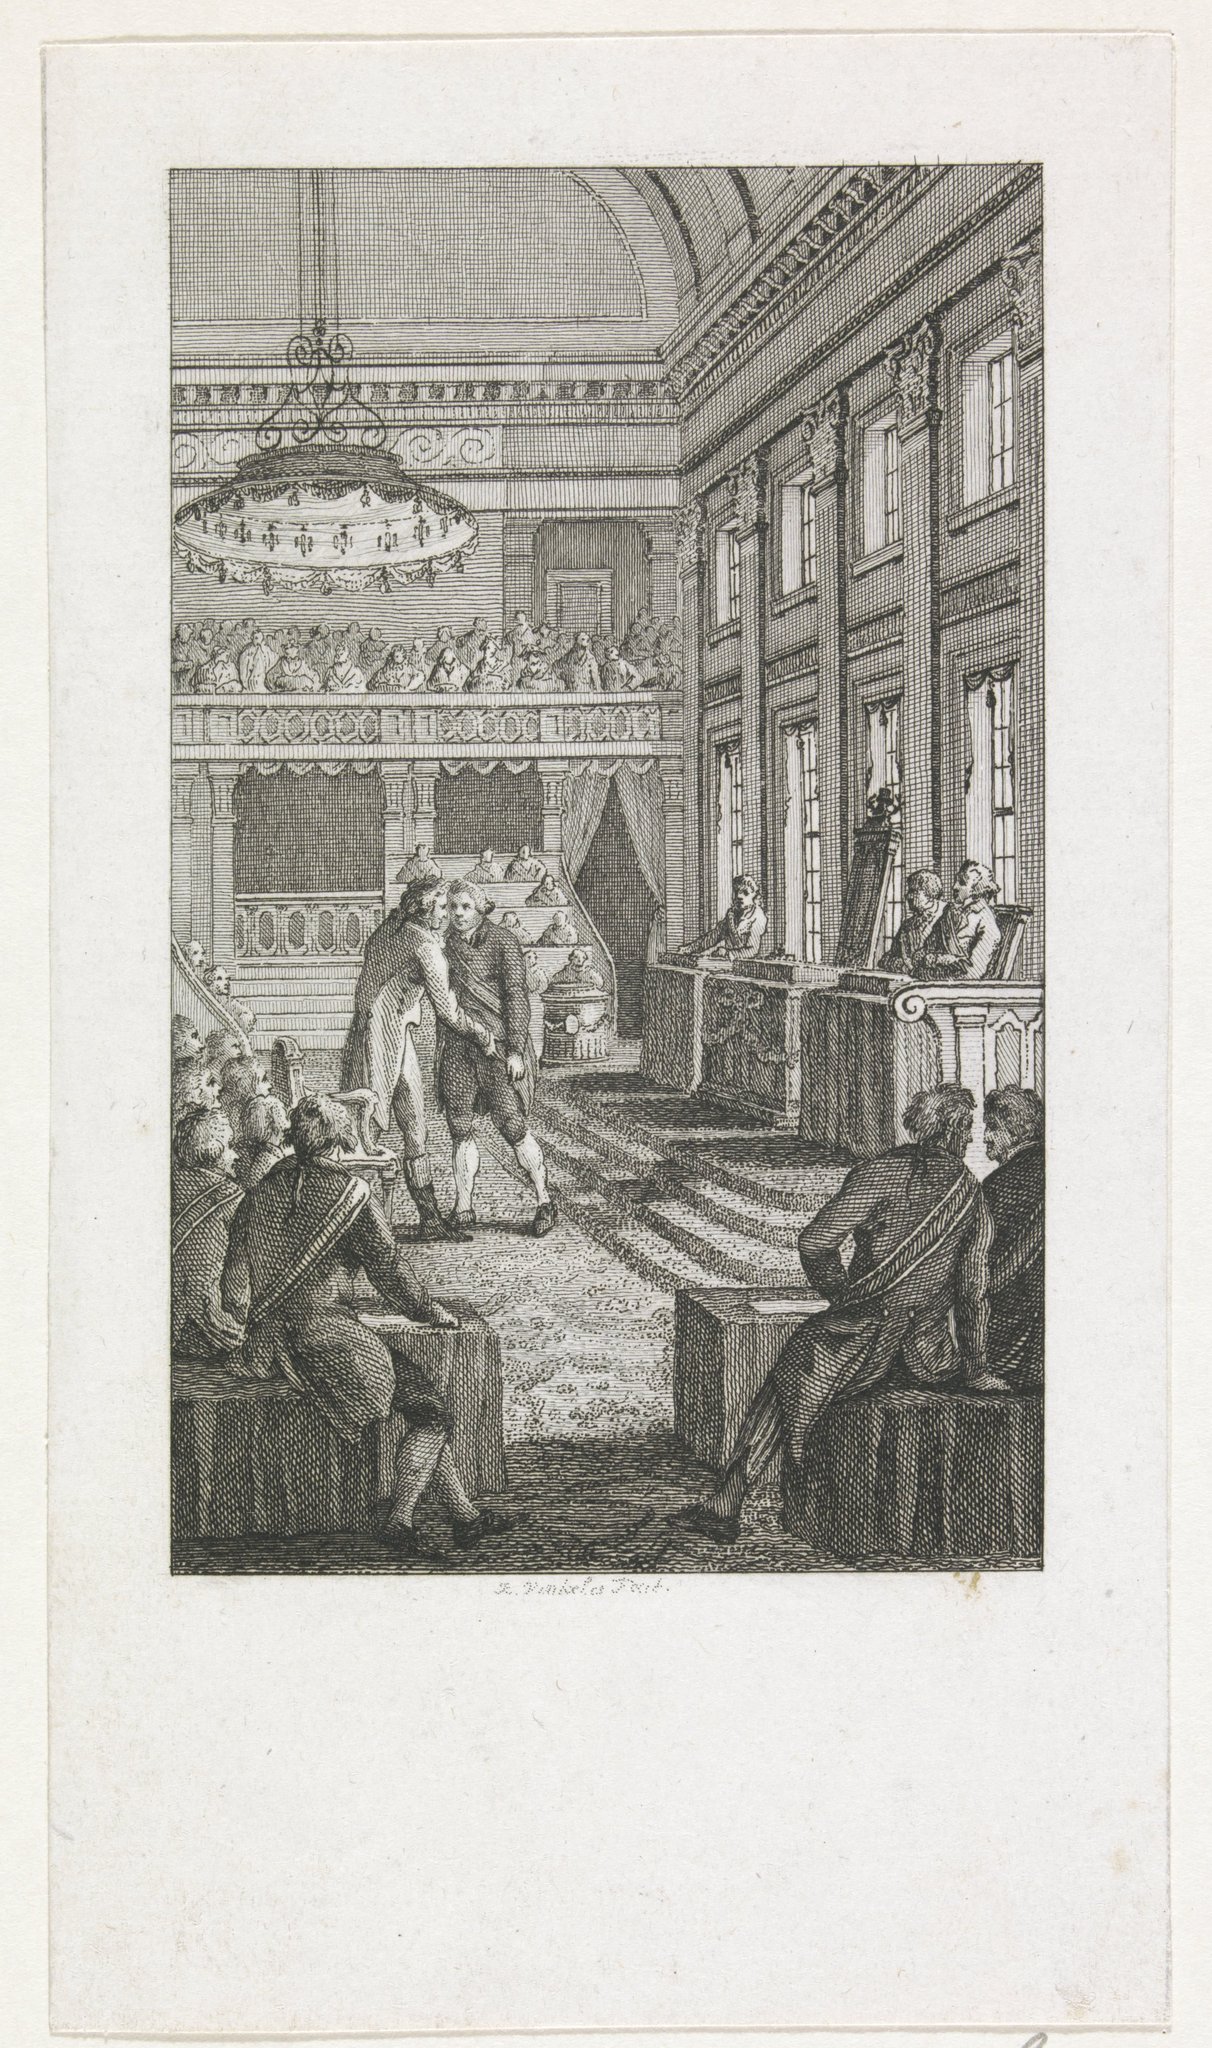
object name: history print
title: Voorzitter Midderigh van de Nationale Vergadering geeft de Franse afgezant De La Croix de broederkus, 1798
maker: reinier vinkeles (i)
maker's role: draughtsman, print maker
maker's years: 1741-1816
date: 1805-1807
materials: paper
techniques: engraving, etching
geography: netherlands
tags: embracing each other, kissing, lower house, parliament, chamber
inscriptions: collector's mark: Lugt 2228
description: Gebruikt als illustratie in: P.A. Loosjes. Vaderlandsche historie, vervattende de geschiedenissen, der Vereenigde Nederlanden (...). Ten onmiddelyken vervolge van Wagenaar's Vaderlandsche historie. Amsterdam: Johannes Allart, dl. 39 (1807).